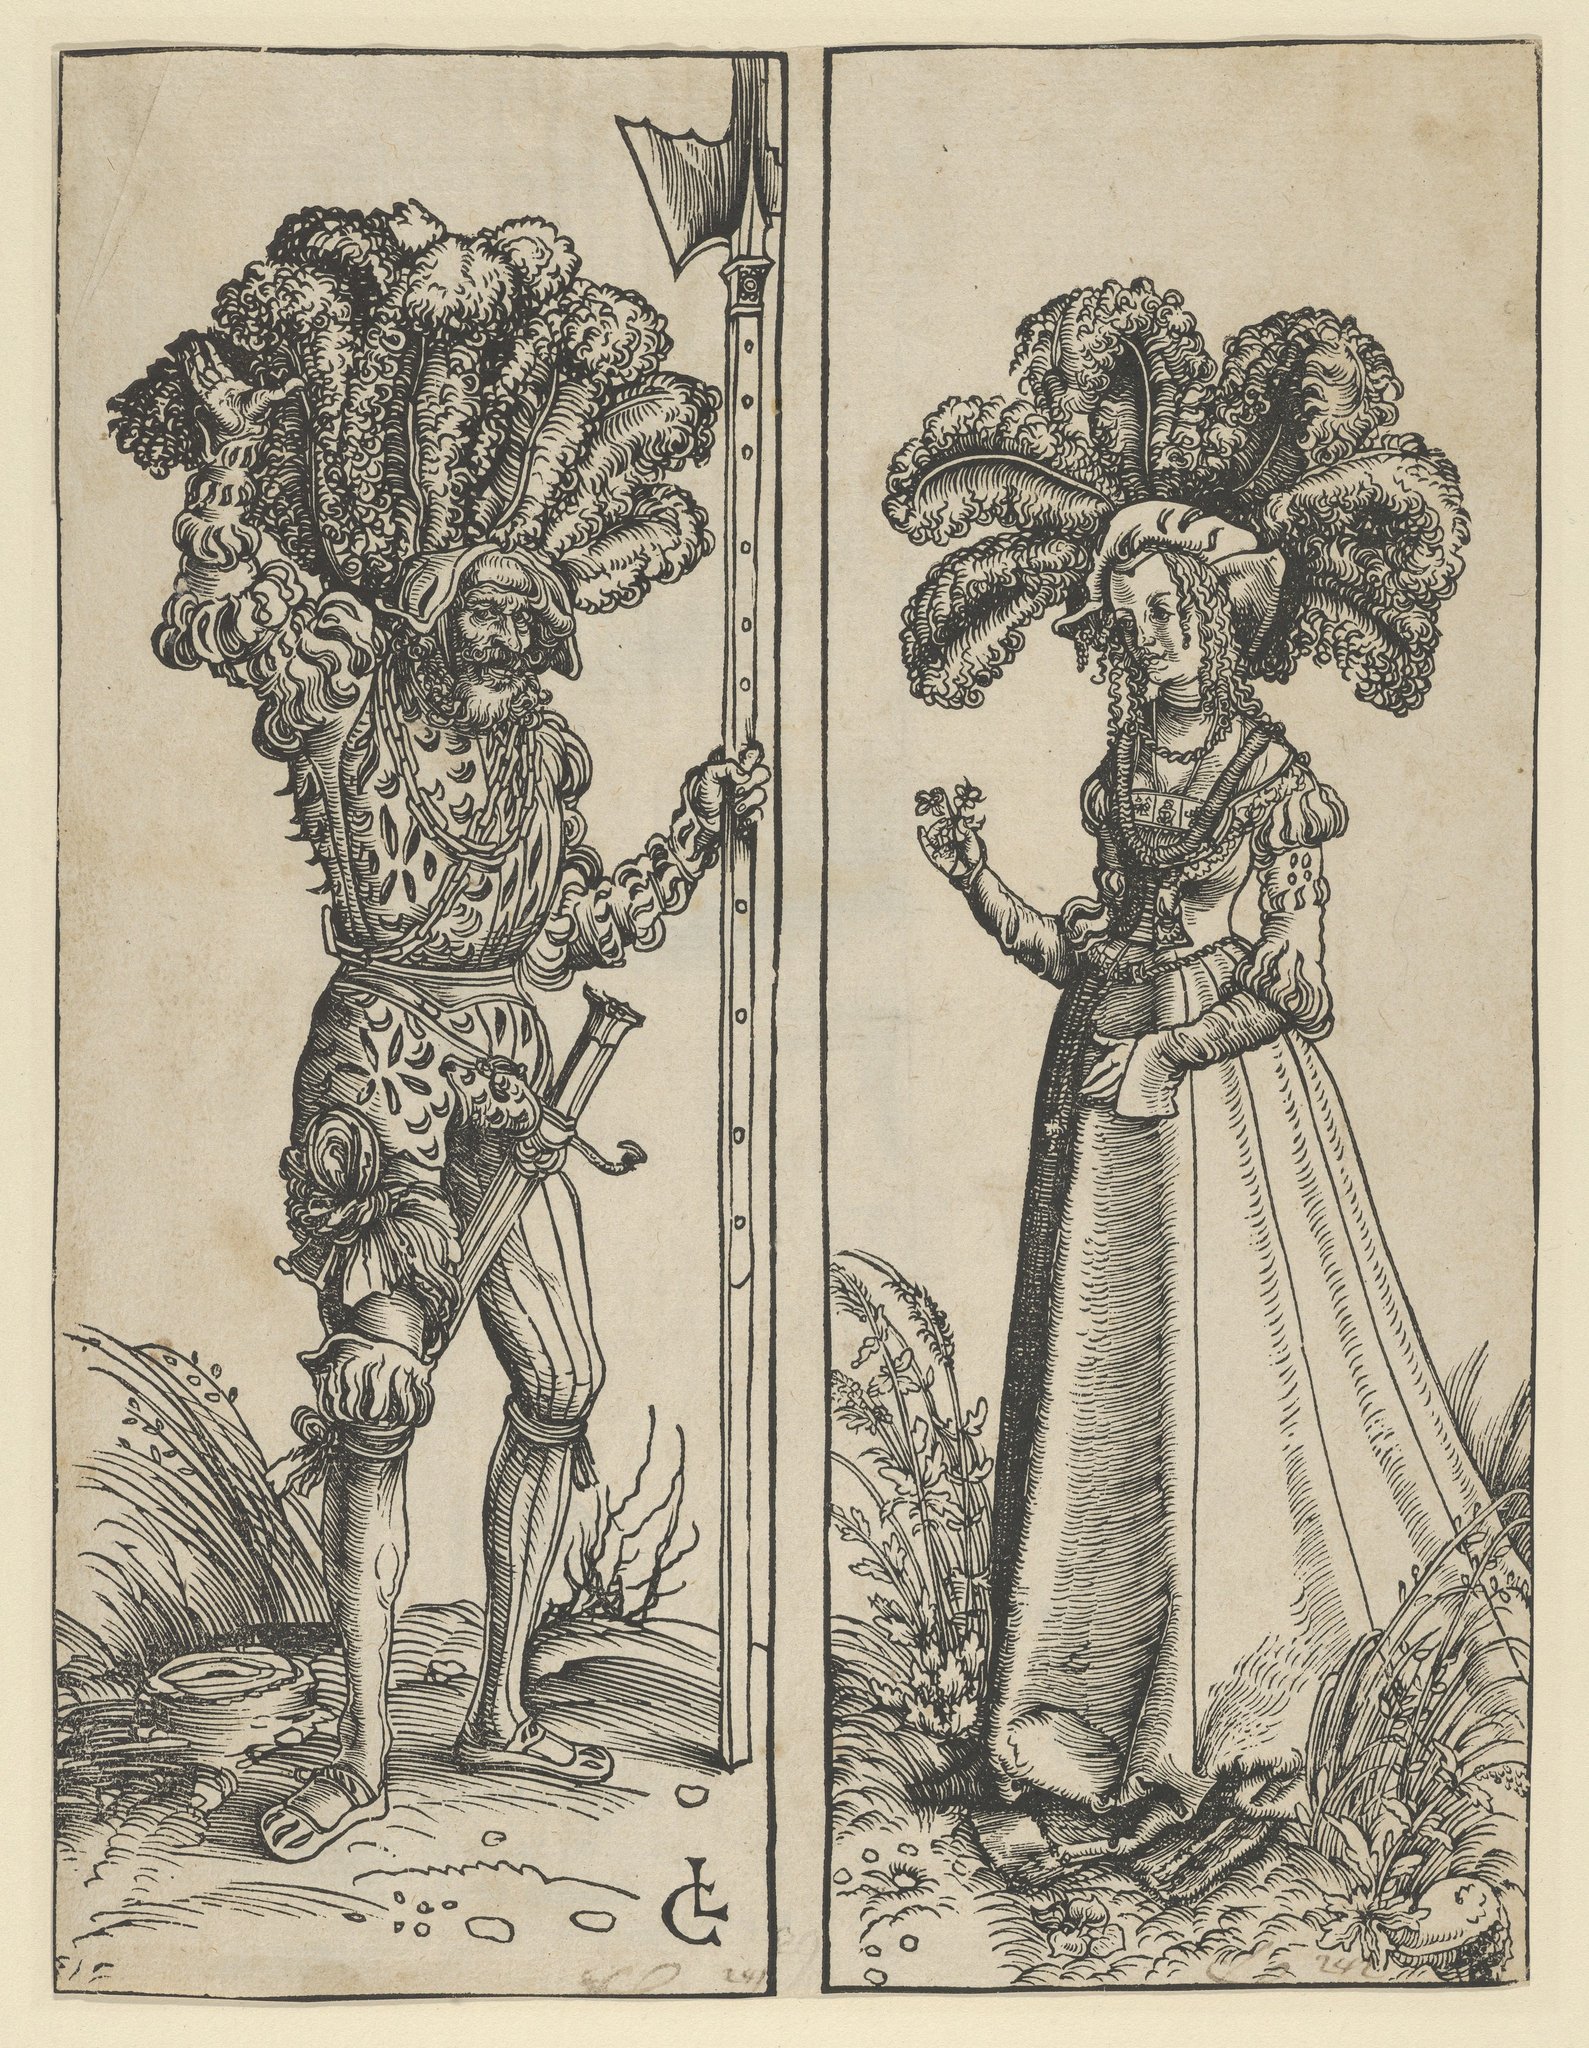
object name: print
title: Footsoldier with Halberd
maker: lucas cranach the elder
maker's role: artist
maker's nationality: german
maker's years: 1472-1553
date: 1472-1553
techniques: woodcut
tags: soldiers,weapons,men,women